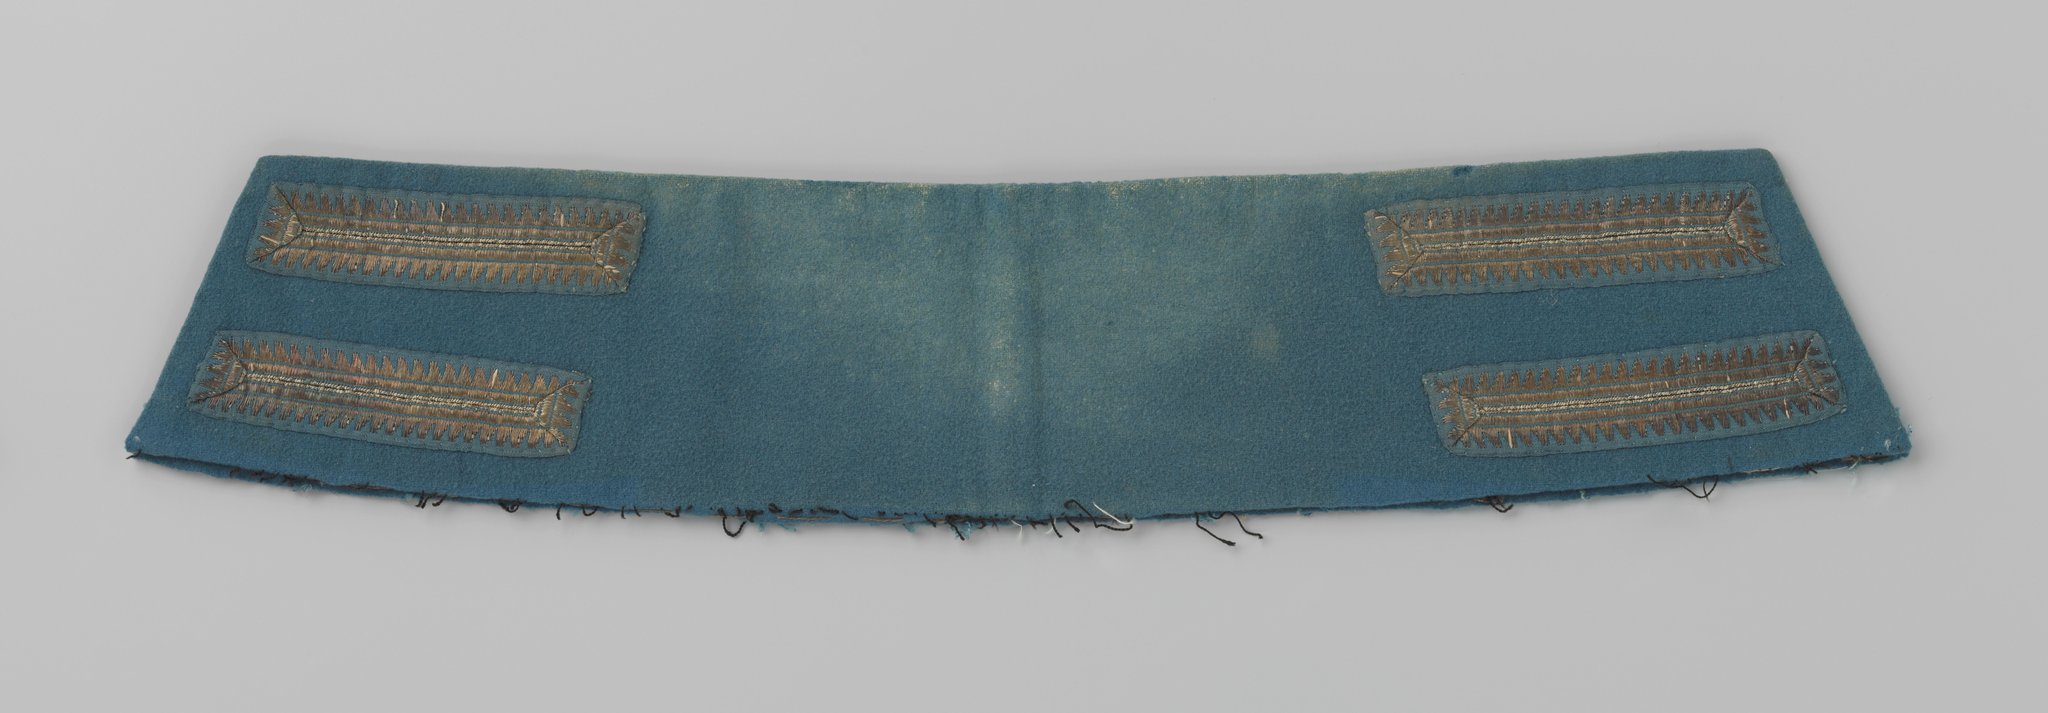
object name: fragment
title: Kraag van blauw laken met borduursel in zilverdraad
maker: Anonymous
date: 1800-1825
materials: textile, thread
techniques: appliqué, embroidered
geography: netherlands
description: Uniformfragmenten bestaande uit: twee kragen, manchetomslagen, paar revers met één en zeven paar lissen, voering en rug- en voorpanden; voor livrei of schutterij (?). Deze uniformfragmenten waren op het moment van invoer nog niet beschikbaar en daar de aantallen e.d. onduidelijk zijn, is bij deze invoer alleen volstaan met de vermelding van de diverse onderdelen. De invoer per onderdeel moet dus nog volgen.